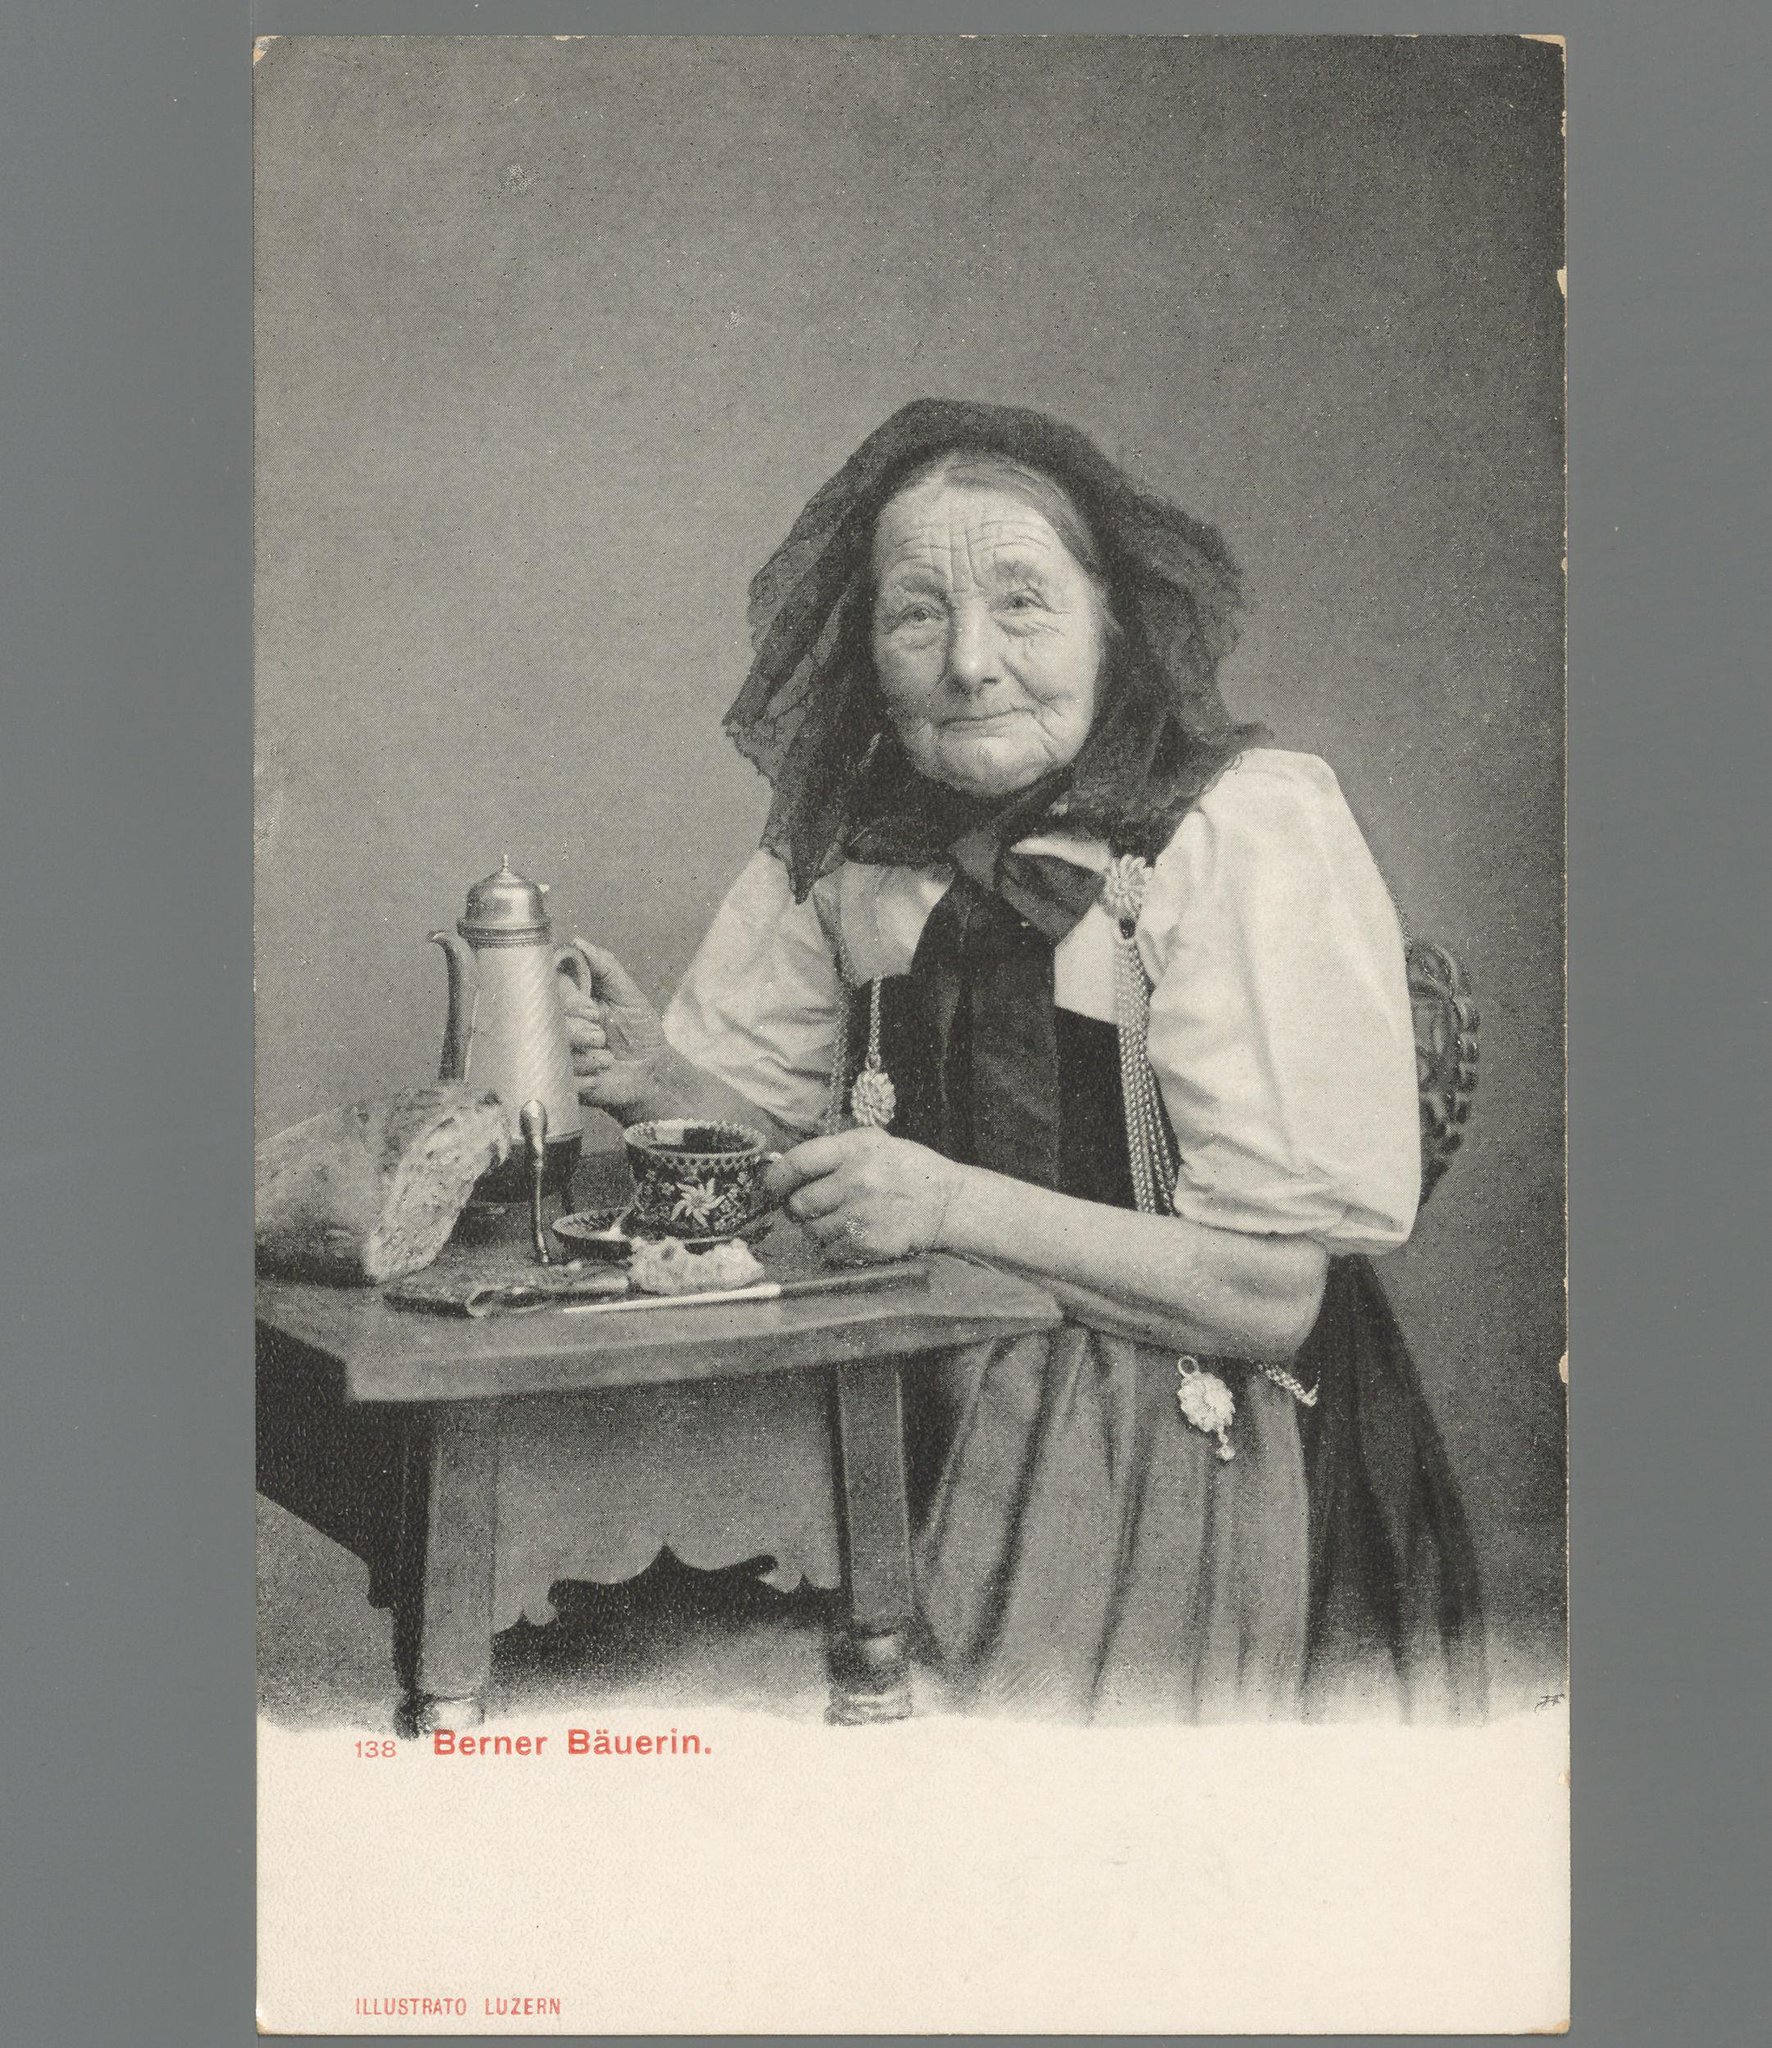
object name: photomechanical print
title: Berner Bäuerin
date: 1890-1905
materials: cardboard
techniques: autotype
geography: bern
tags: farmers - aa - female farmer, farmer's wife, folk costume, regional costume, tea- and coffee-service